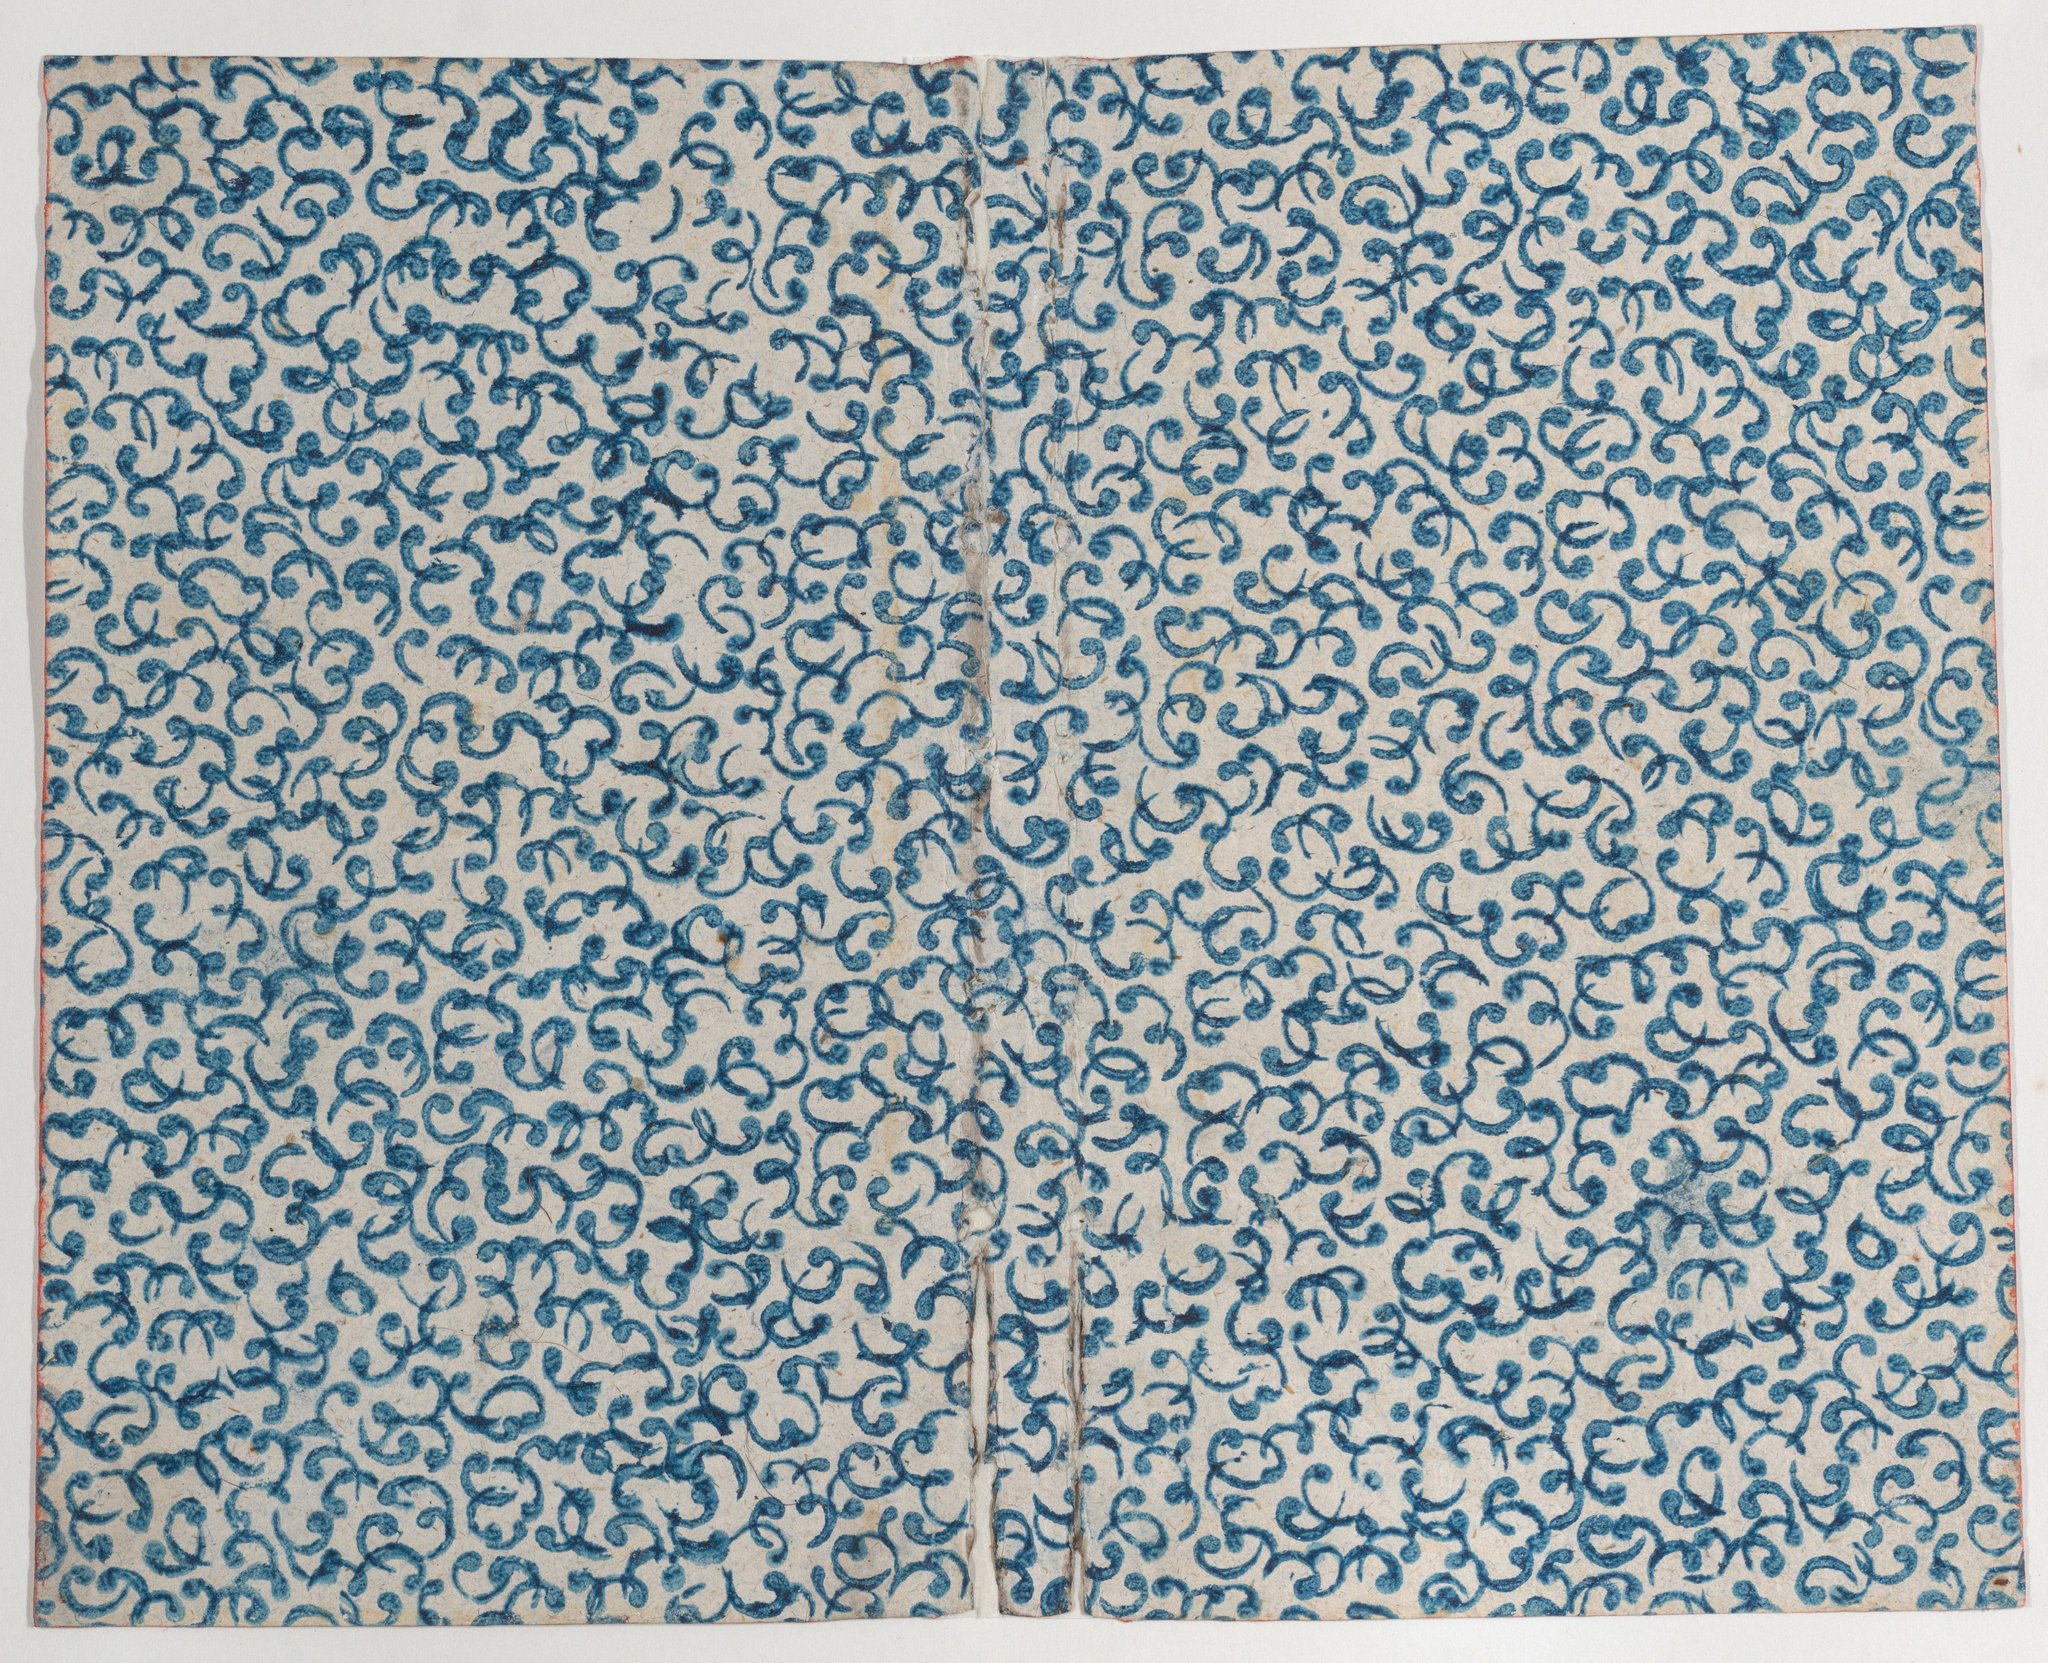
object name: print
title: Book cover with blue curved line pattern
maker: Anonymous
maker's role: artist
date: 1801-1900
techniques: relief print